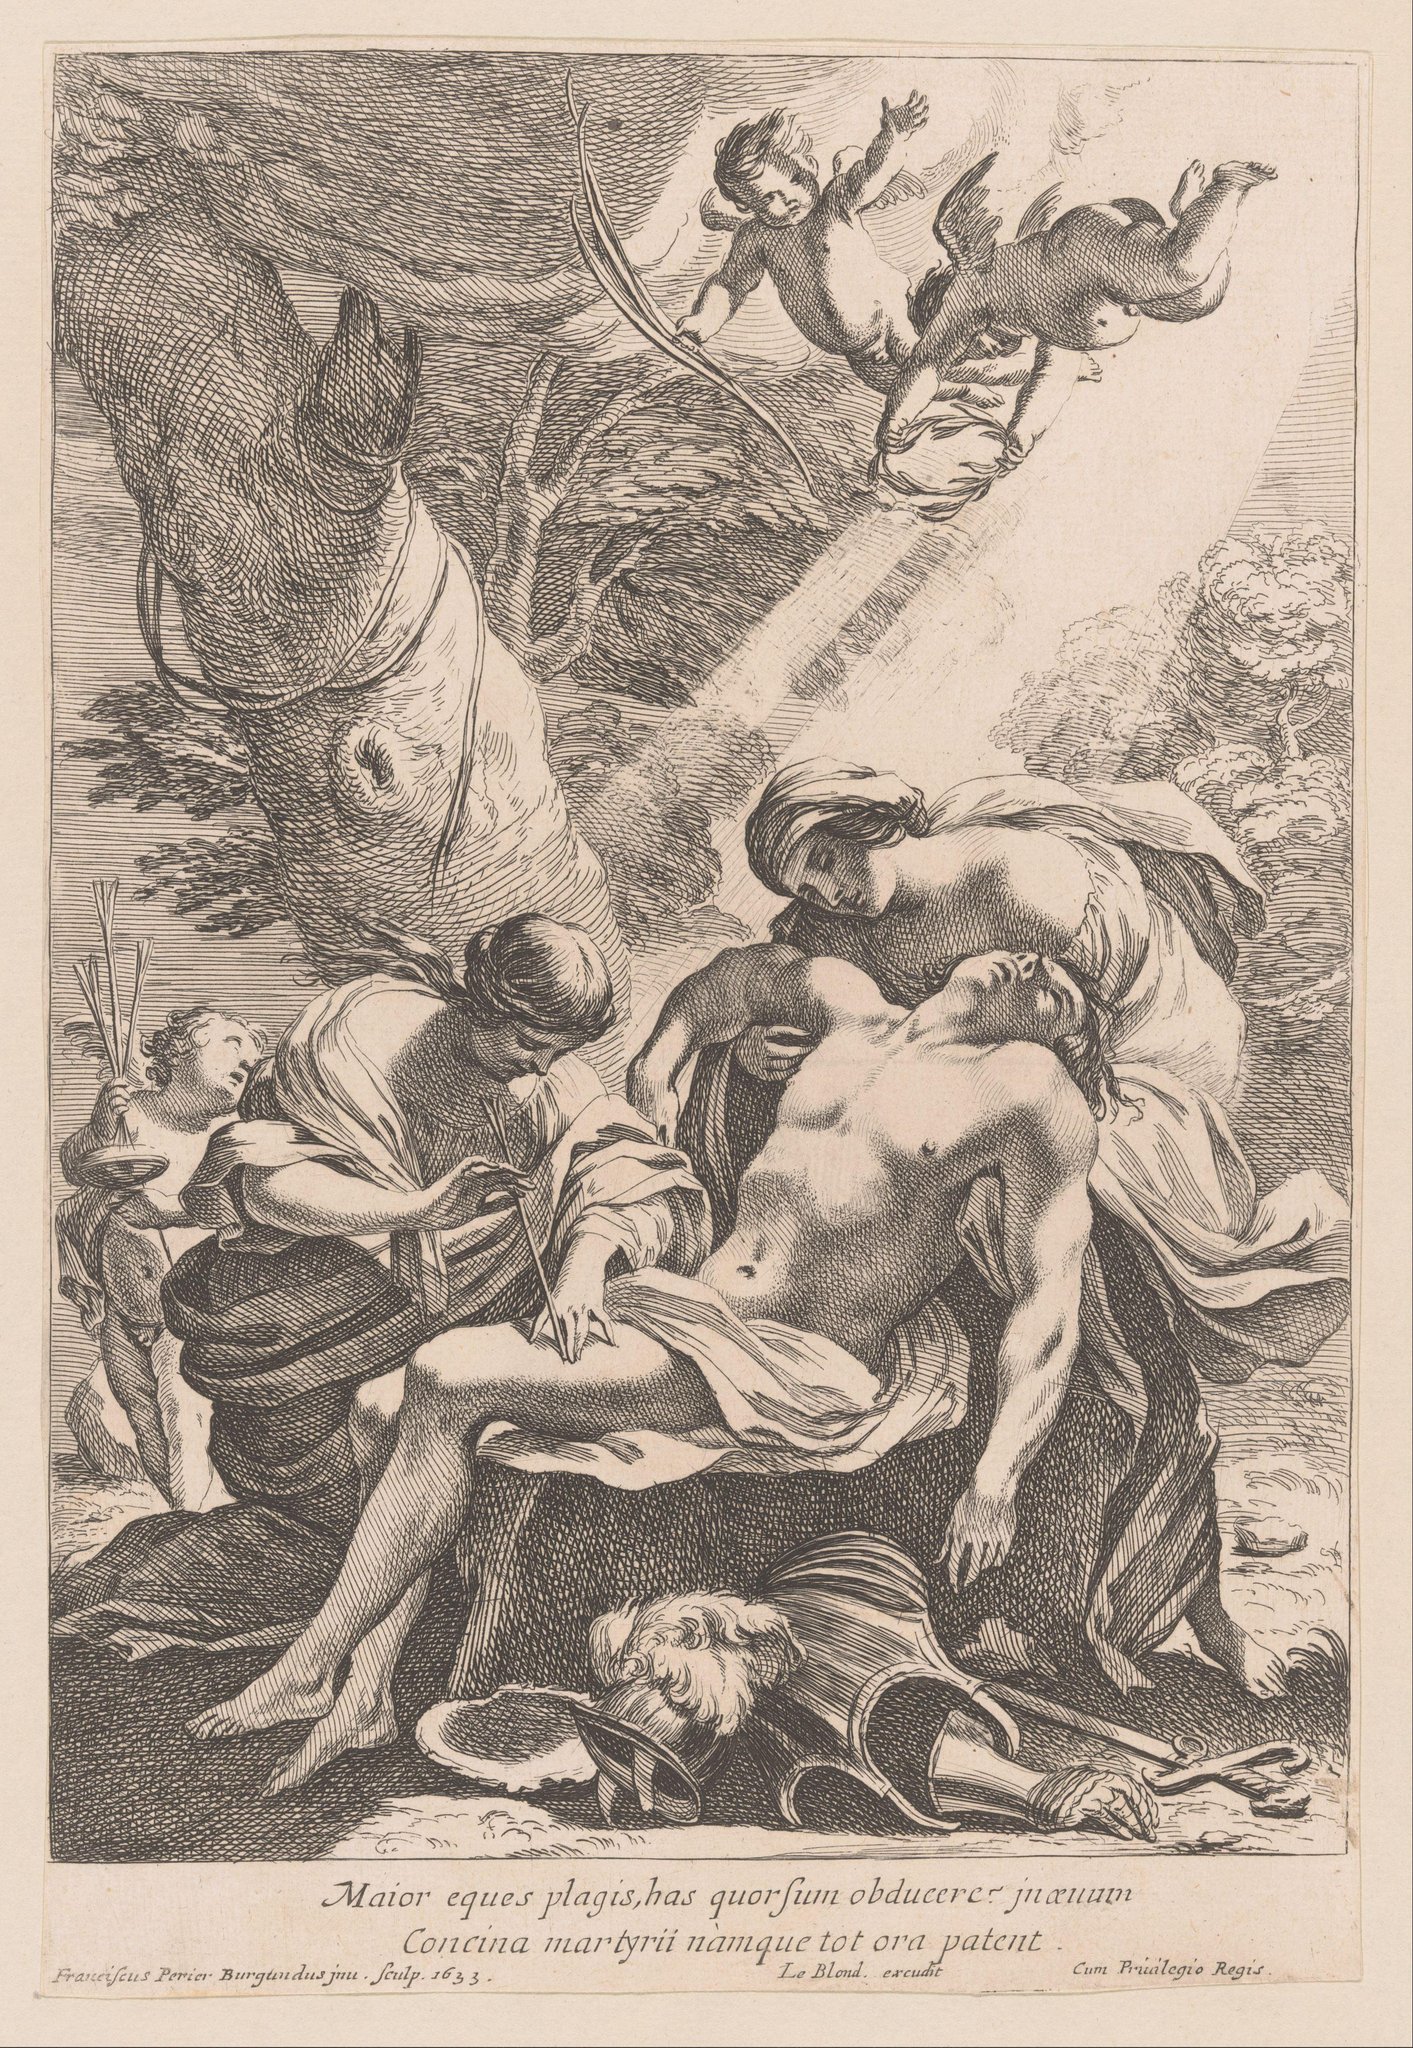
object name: print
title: Maior eques plagis has quorsum obducere (...)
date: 1633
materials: paper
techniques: etching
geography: france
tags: martyrdom, suffering, misfortune, death of st. sebastian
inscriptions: collector's mark: Lugt 240